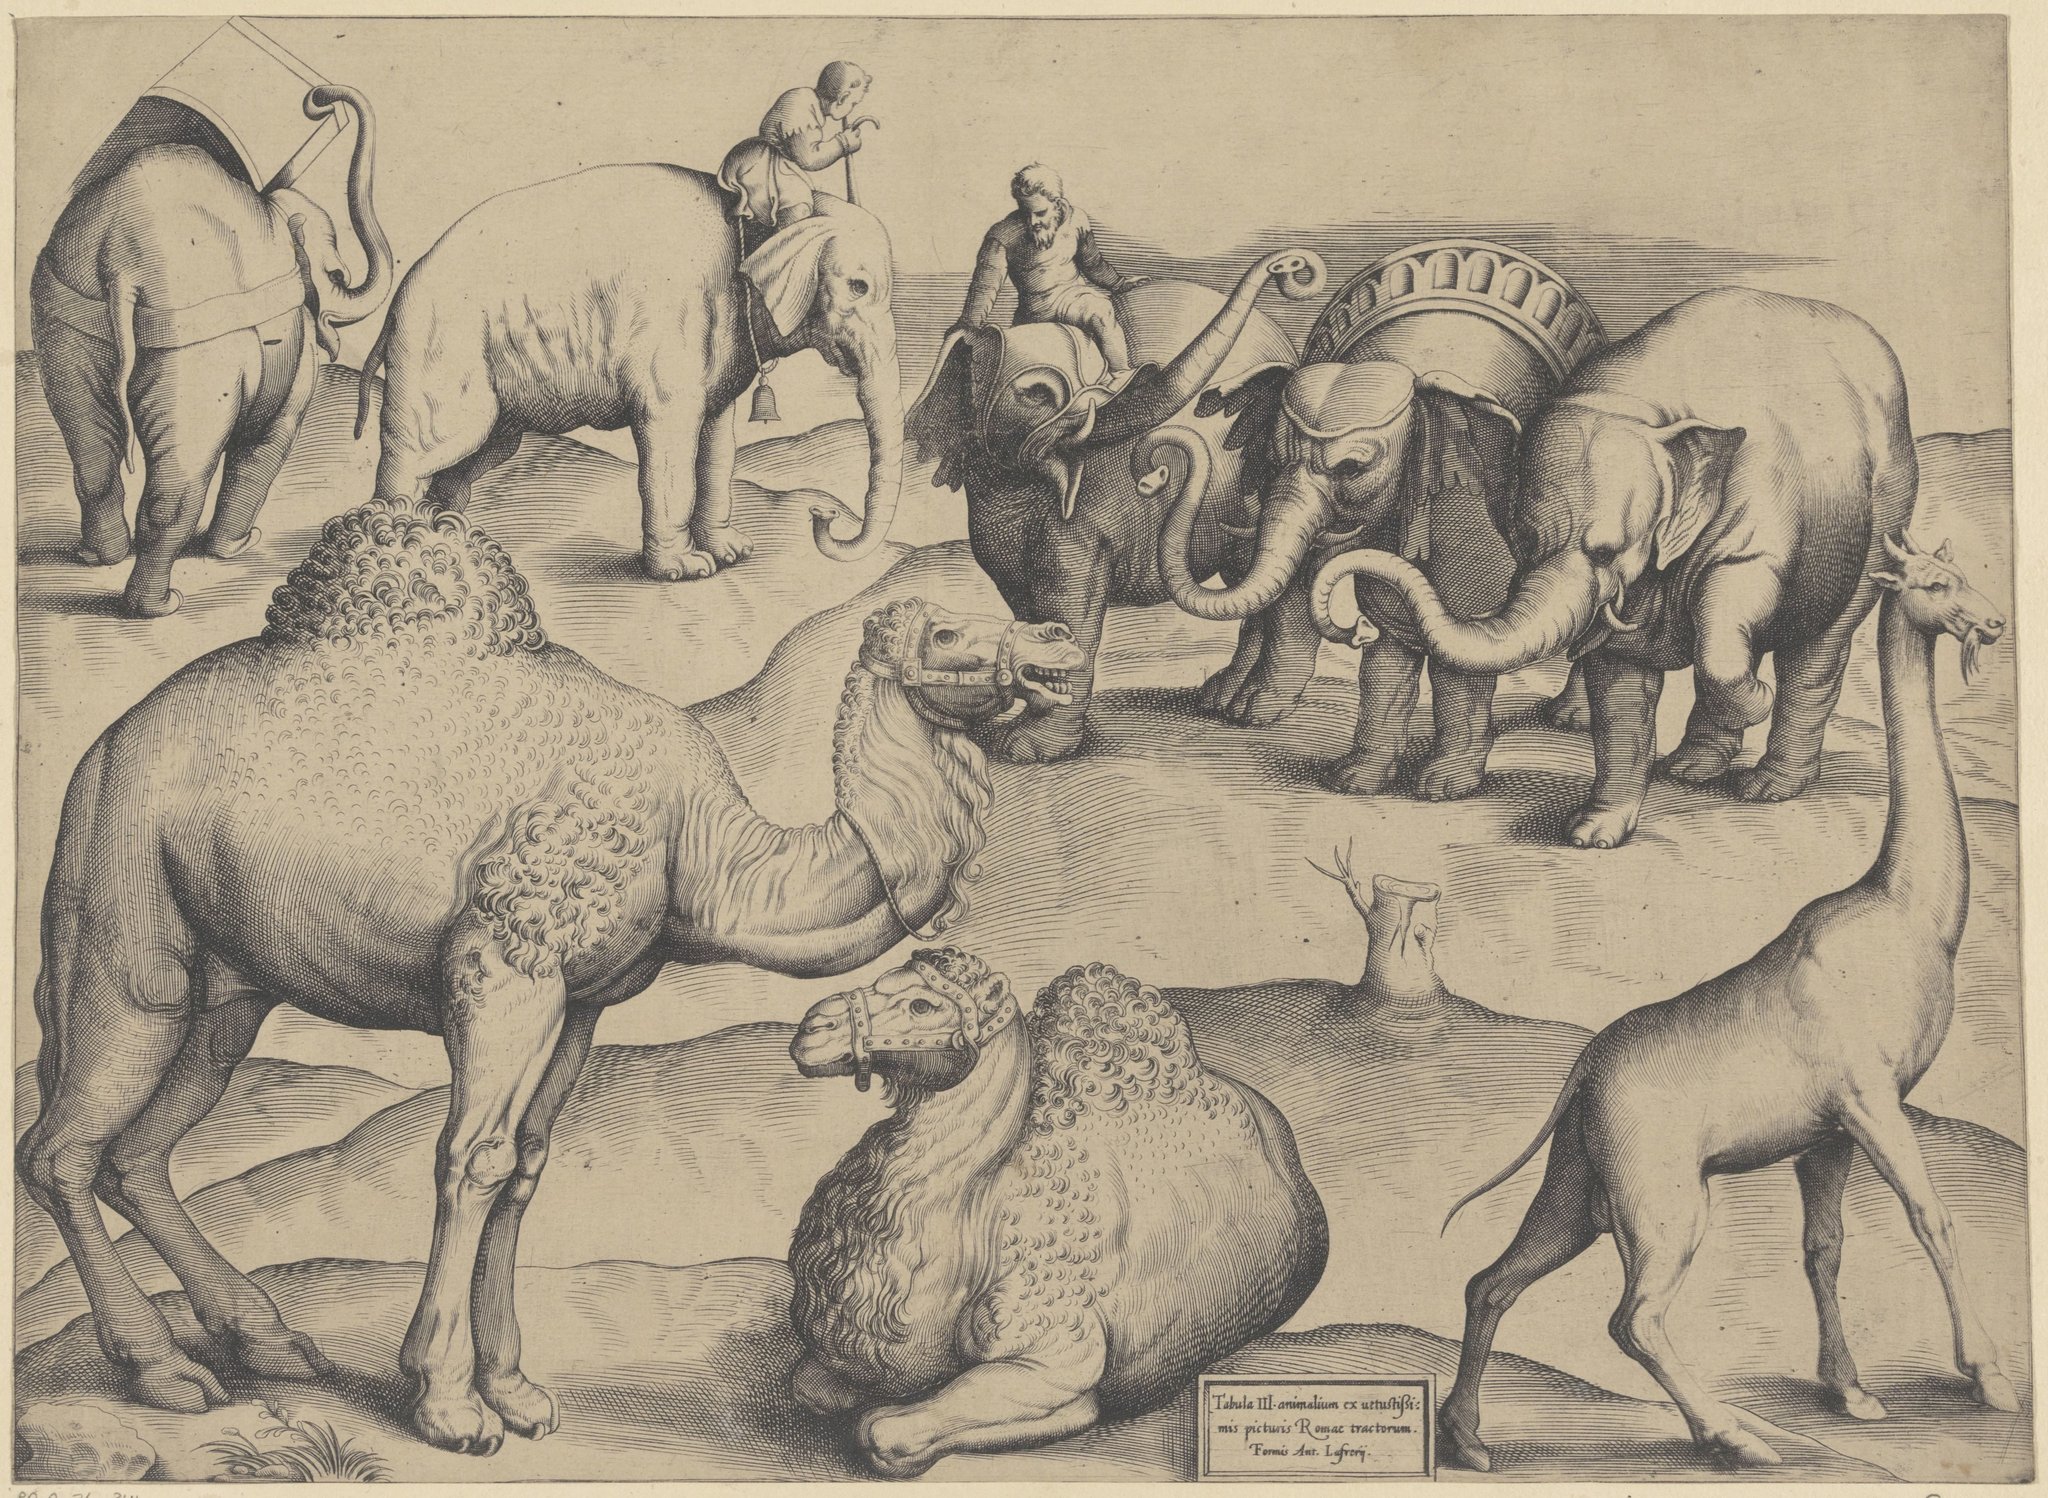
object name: print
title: Speculum Romanae Magnificentiae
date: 1522-1577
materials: paper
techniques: etching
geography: rome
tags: hoofed animals: dromedary, hoofed animals: giraffe, trunked animals: elephant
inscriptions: collector's mark: Lugt 240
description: Deze prent behoort tot het prentcorpus dat bekend staat als de ‘Speculum Romanae Magnificentiae’ (‘Spiegel van Romeinse pracht’). Dit corpus, bestaande uit prenten met voorstellingen van kunstwerken en gebouwen uit het antieke en het moderne Rome, vond zijn oorsprong bij uitgevers Antonio Salamanca en Antonio Lafreri. Deze twee buitenlandse uitgevers bundelden hun krachten te Rome in de periode 1553-1563. Hun prenten werden al snel razend populair bij toeristen en verzamelaars, die de prenten individueel of in grote groepen aanschaften. Grote groepen Speculum-prenten werden vaak op aanvraag samengebonden in albums. Er zijn verschillende Speculum-albums overgeleverd die allemaal verschillen van inhoud. Tussen 1573 en 1577 gaf Antonio Lafreri een speciale titelpagina uit (met de titel ‘Speculum Romanae Magnificentiae’) die mensen voor hun verzamelingen konden voegen. Het overlijden van Lafreri in 1577 betekende niet het einde van het corpus. Een groot deel van de koperplaten ging over op Claudio en Stefano Duchetti. De rest raakte verspreid over verschillende andere uitgevers. De populariteit van de Speculum-prenten wist nog geruime periode uitgevers te inspireren tot het laten maken van kopieën en het toevoegen van nieuwe prenten aan het corpus.